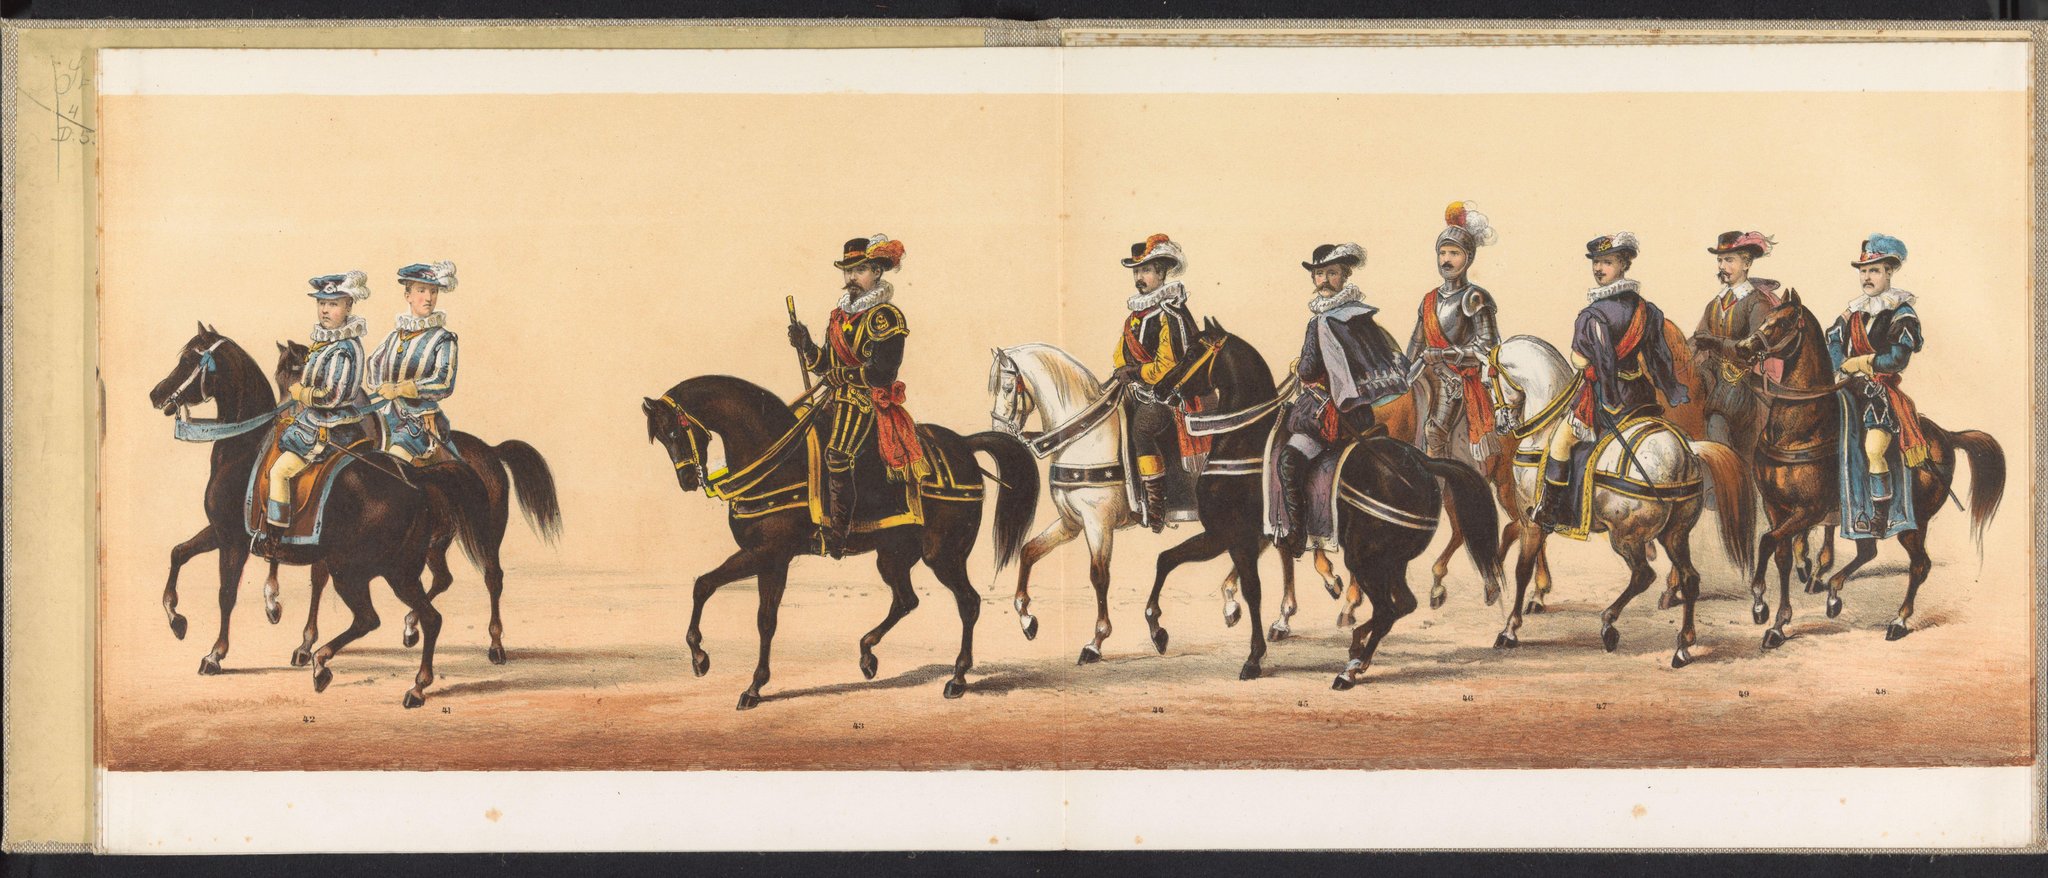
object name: print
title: Optocht te Haarlem, 1872 (plaat 6)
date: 1872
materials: paper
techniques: chromolithography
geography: haarlem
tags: festivities on events of national importance (+ parade, pageant, cavalcade ~ festive activities), costumes used in pageants, haarlem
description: Feestelijke optocht gehouden te Haarlem tijdens de Aprilfeesten op 1 april 1872 ter gelegenheid van het 300-jarige onafhankelijkheid van Nederland. Zesde plaat met de groepen genummerd 41-49. Onderdeel van de serie van twaalf aaneen geplakte bladen.